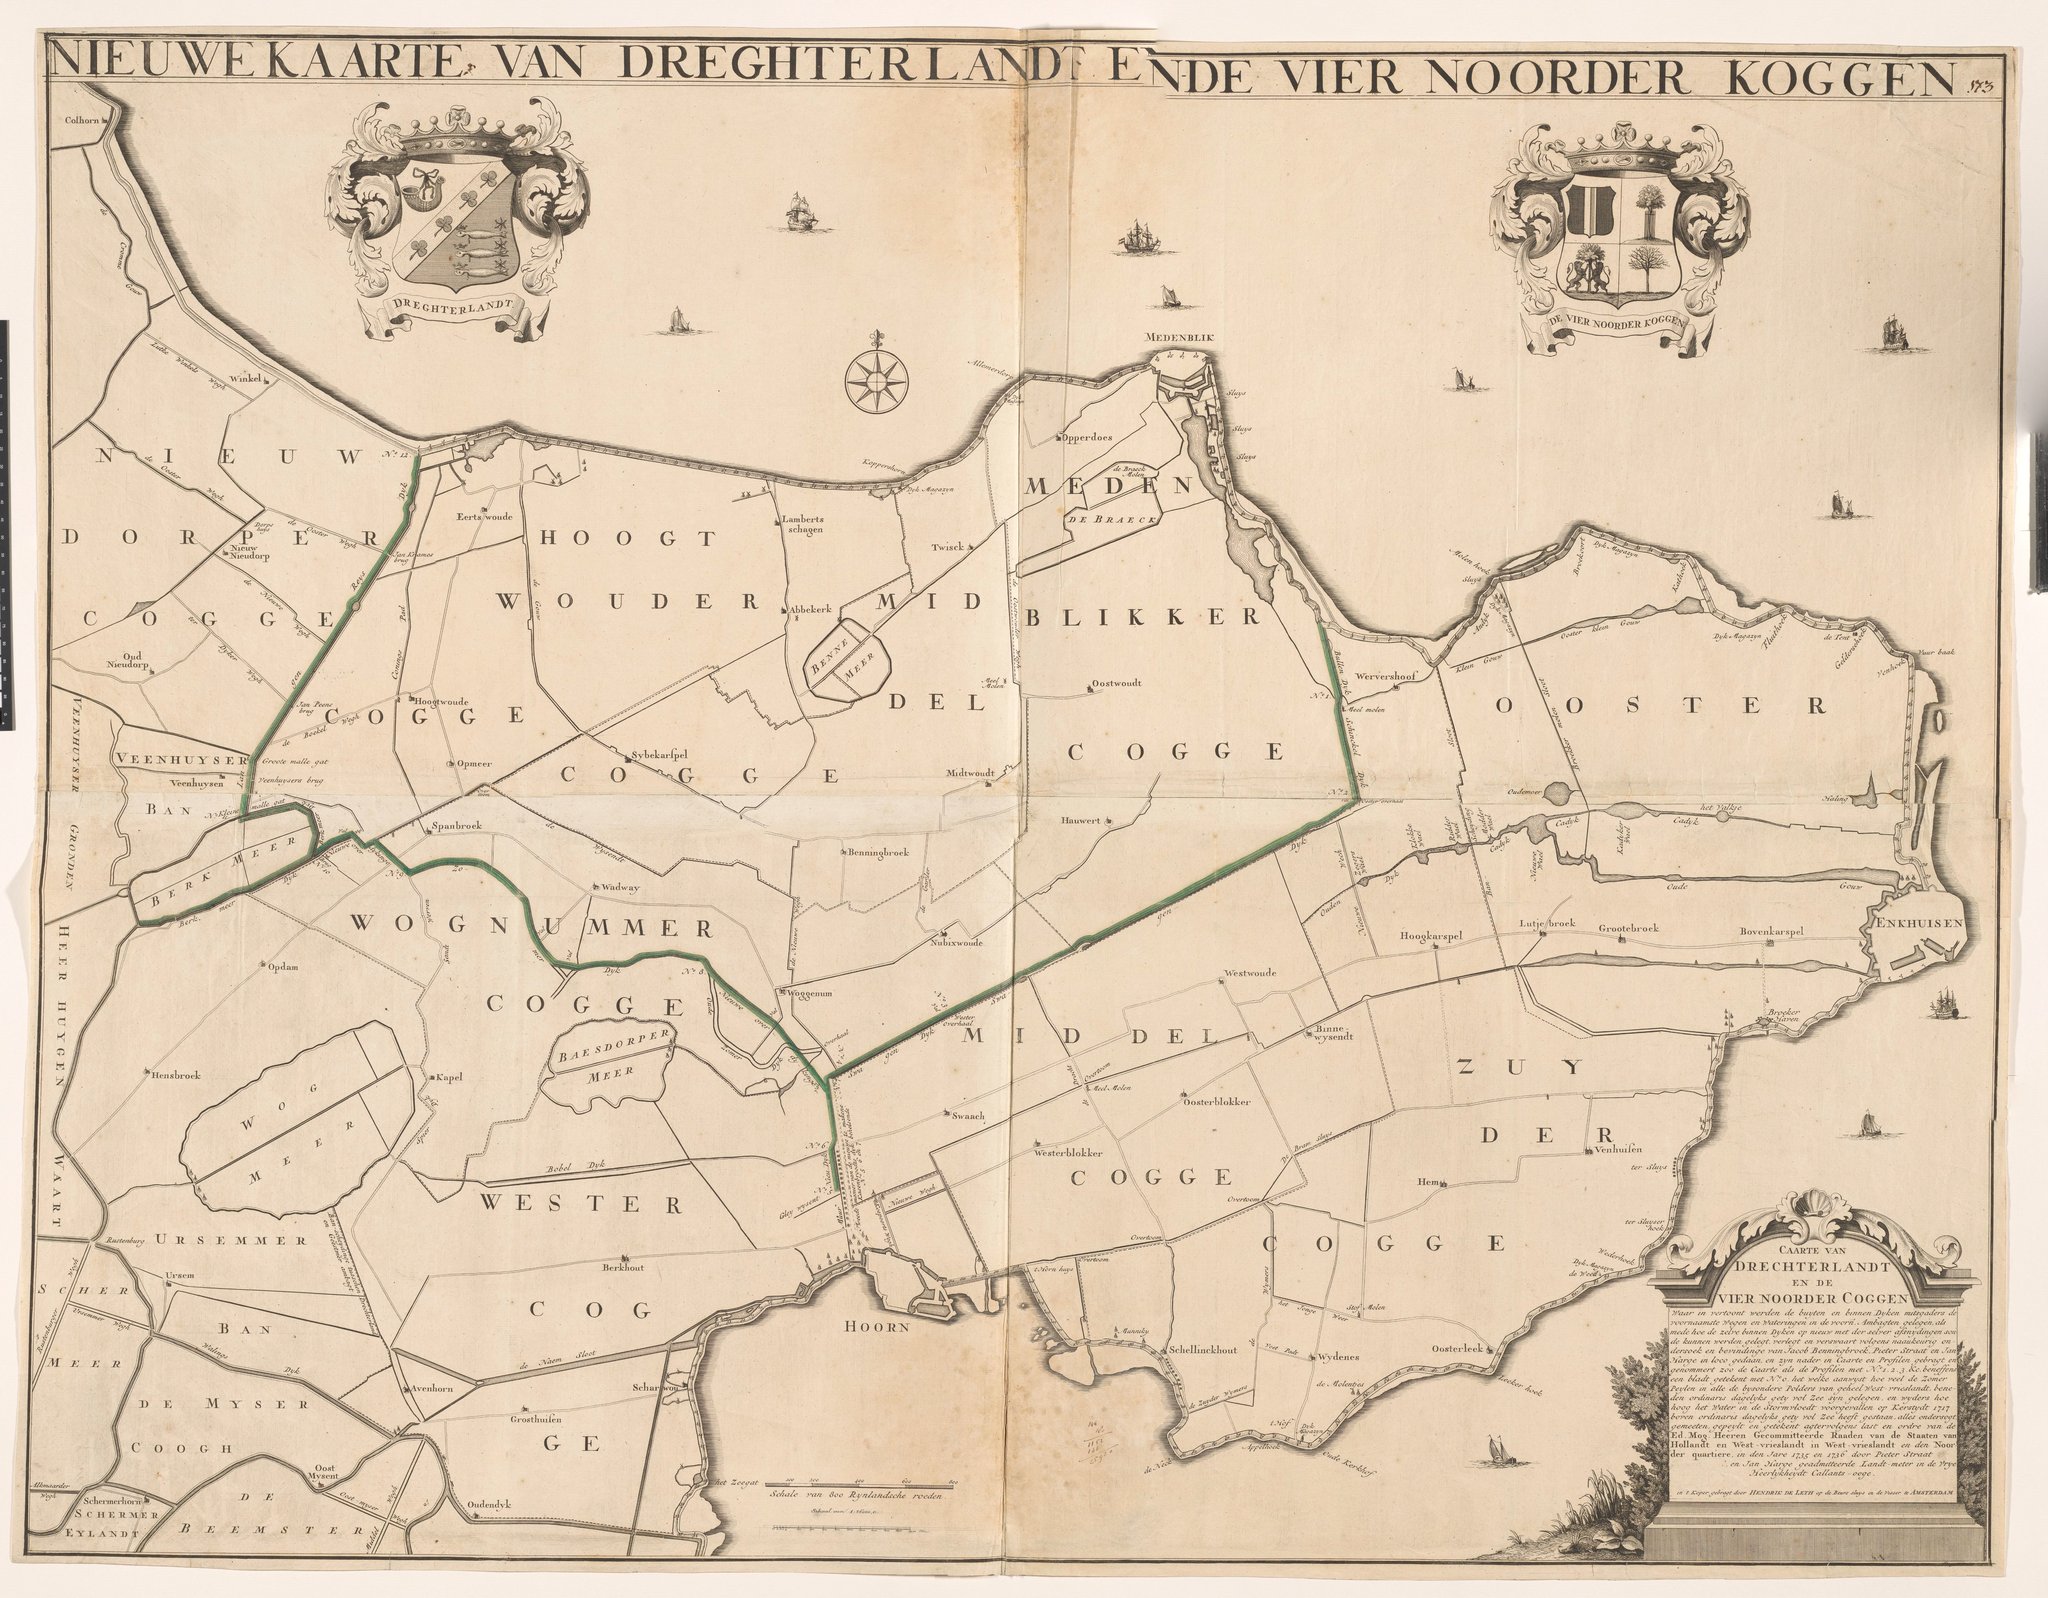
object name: print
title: Kaart van de ambachten Drechterland en de Vier Noorder Koggen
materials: ink, paper, pencil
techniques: engraving, etching, hand coloring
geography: north holland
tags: coat of arms (as symbol of the state, etc.), maps of separate countries or regions, dikes, levee, polder, reclaimed land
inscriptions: collector's mark: Lugt 19, inscription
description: Langs de bovenkant de eerste titel. Linksboven het wapen van het ambacht Drechterland, rechtsboven dat van het ambacht de Vier Noorder Koggen. Onderaan in het midden een schaalstok: Schale van 800 Rynlandsche roeden. Rechtsonder een cartouche met de tweede titel. Met de groene lijn is de binnendijk aangegeven.